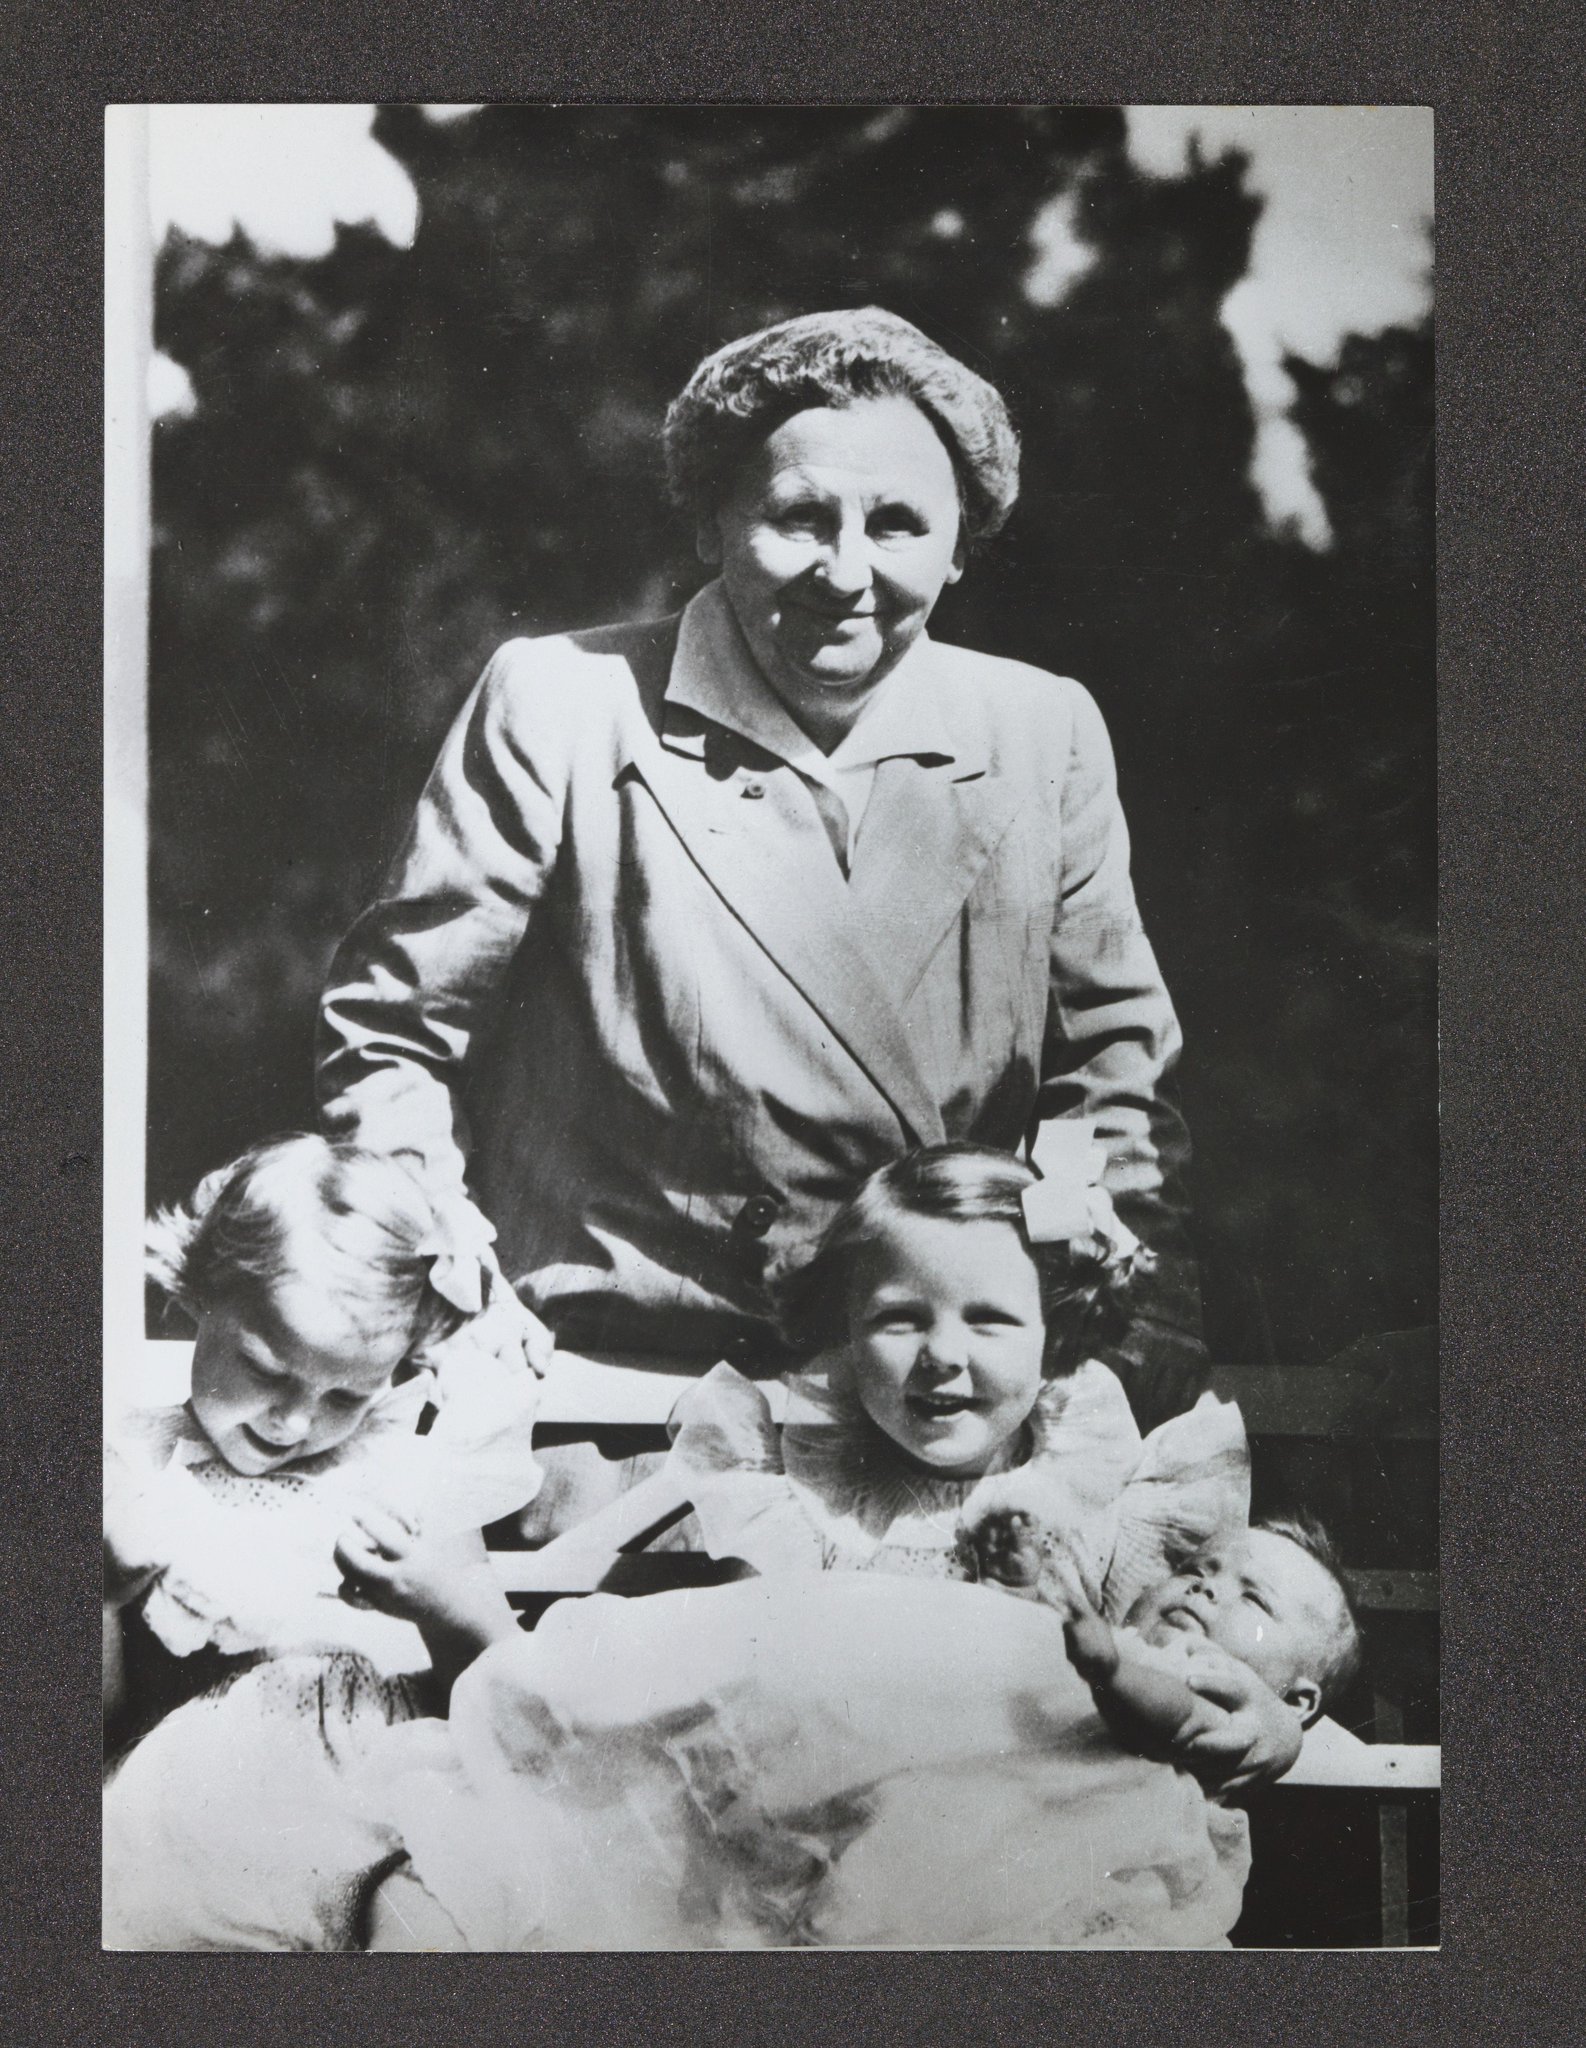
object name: photograph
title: Portret van de prinsessen Beatrix en Irene met op schoot prinses Margriet, achter hen Koningin Wilhelmina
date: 1943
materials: paper, photographic support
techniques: gelatin silver print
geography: amsterdam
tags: wilhelmina of the netherlands, beatrix (koningin der nederlanden)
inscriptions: stamp: ‘Copyright ANEFO Kerkstraat 310 Amsterdam-c’